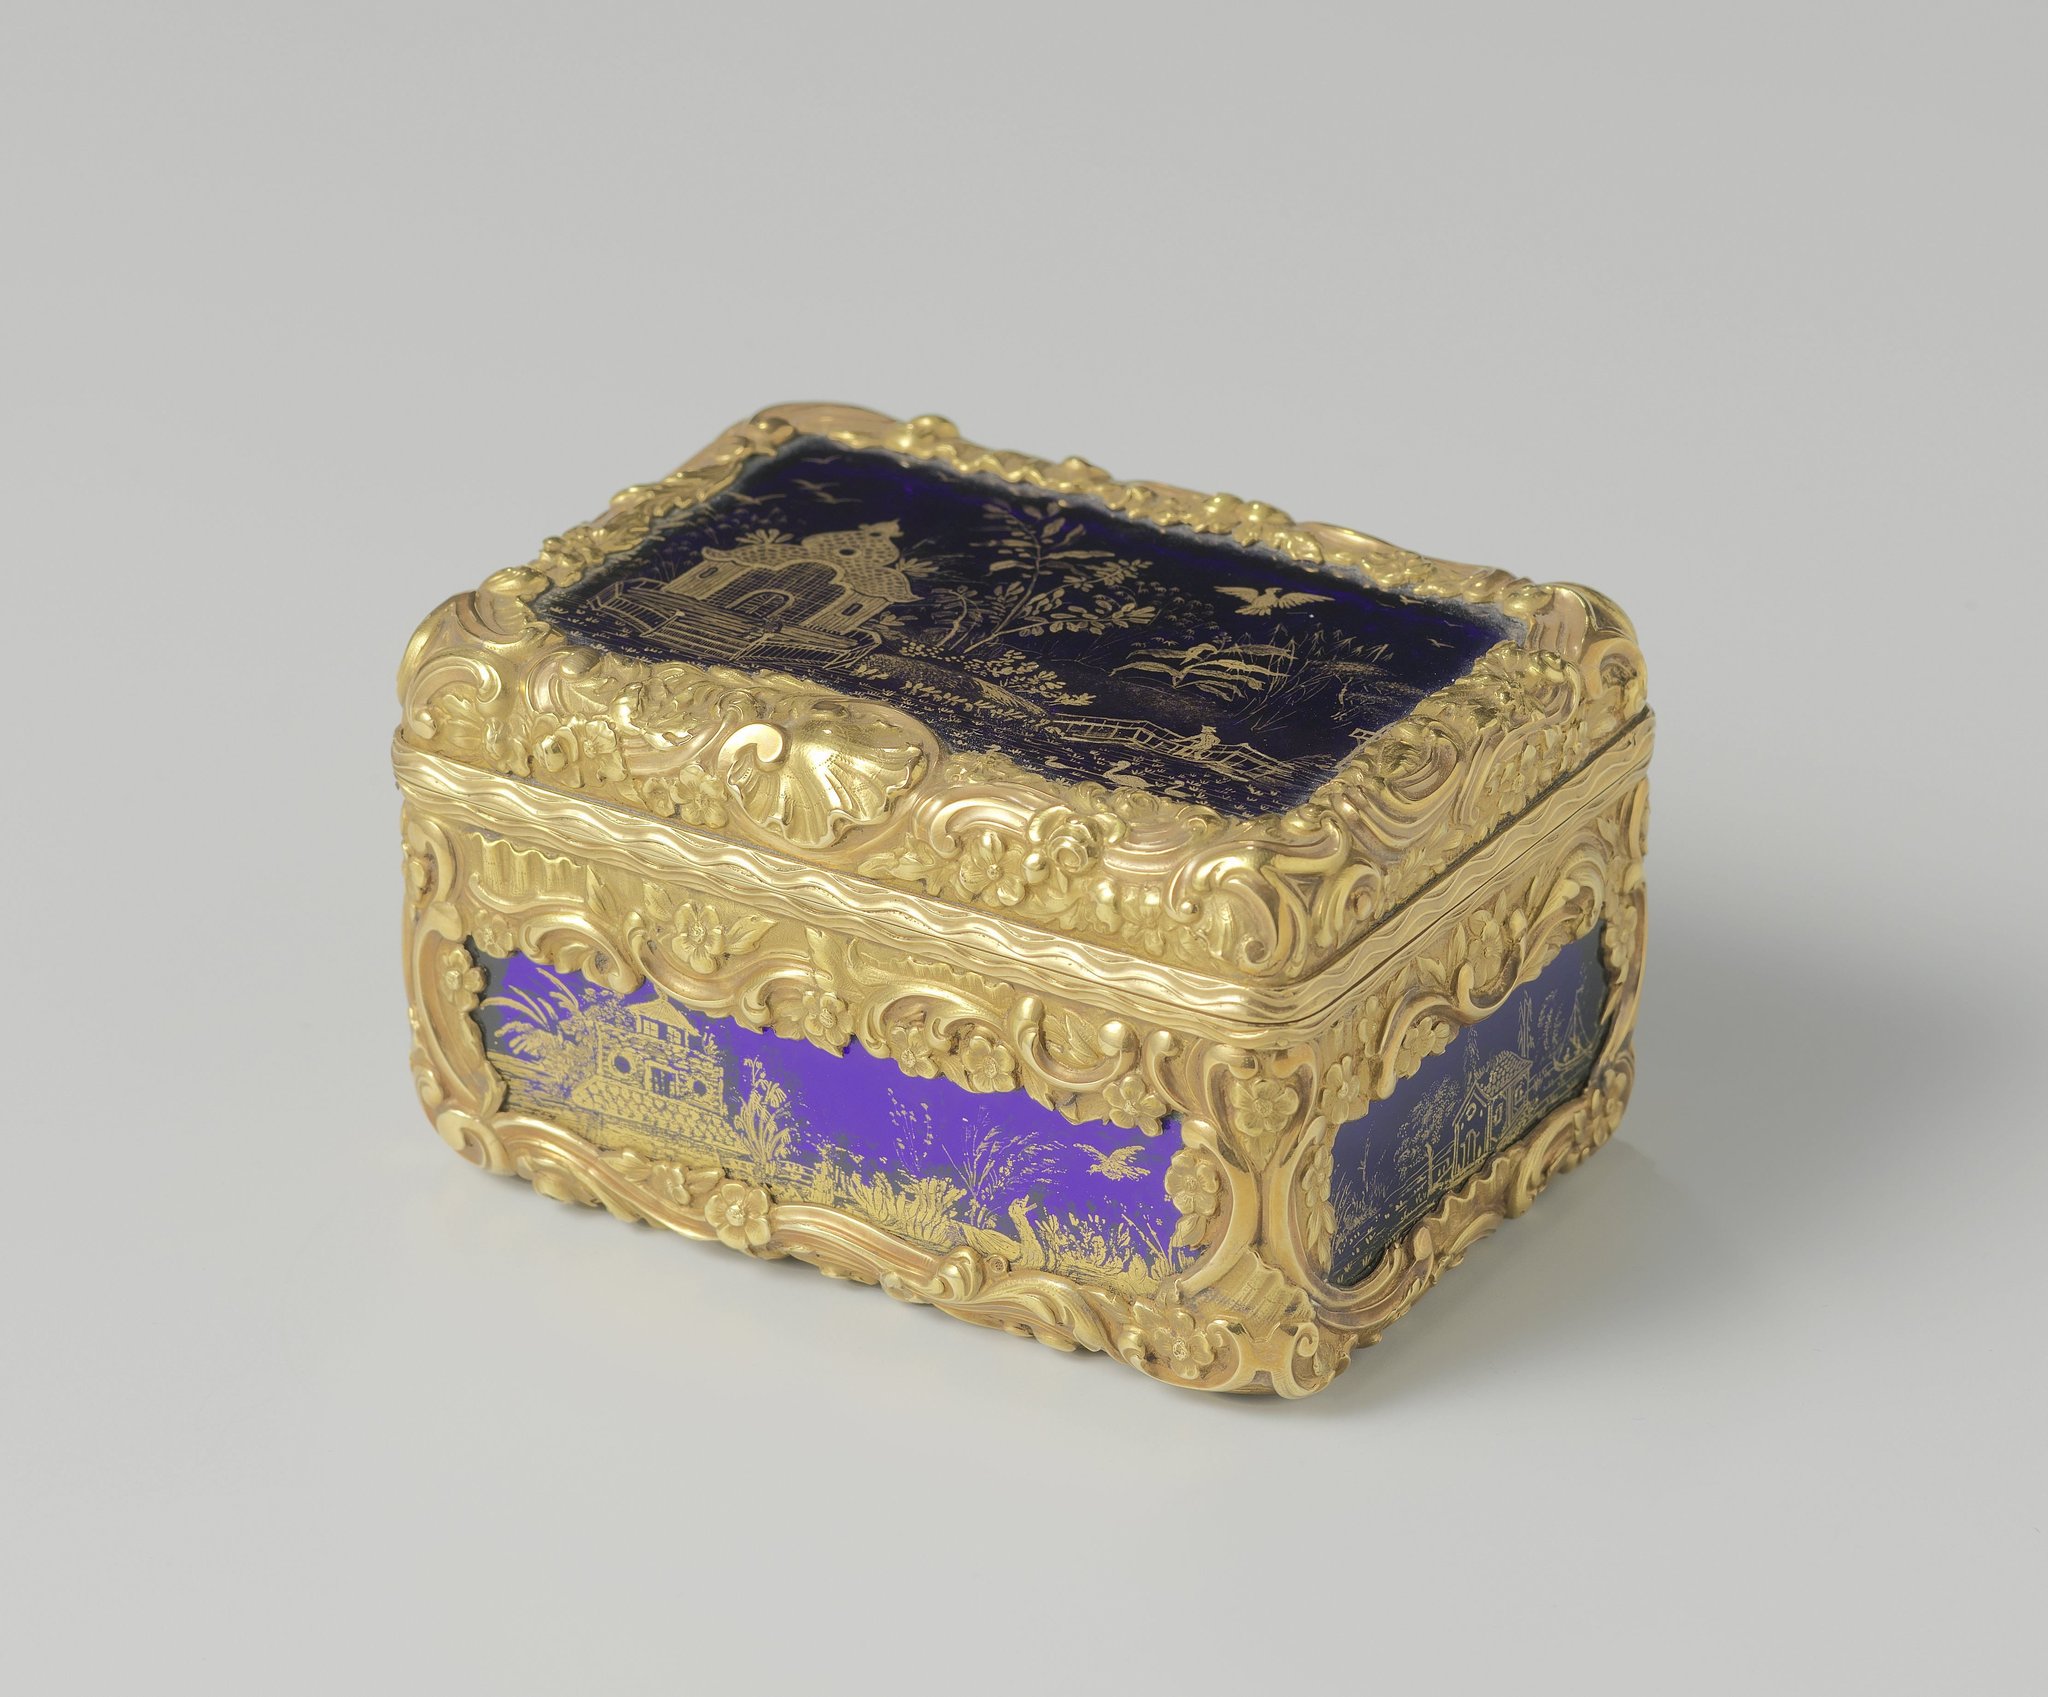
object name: snuffbox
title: Doos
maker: Anonymous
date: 1800-1850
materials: glass, gold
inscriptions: date letter (false), duty mark (false), maker's mark (false): ‘DFP’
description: De doos is vervaardigd in de eerste helft van de 19e eeuw, geïnspireerd op Engelse 18e-eeuwse exemplaren, maar voorzien van valse 18e-eeuwse Parijse merken. R.J. Baarsen in: Murdoch & Zech, 2014.